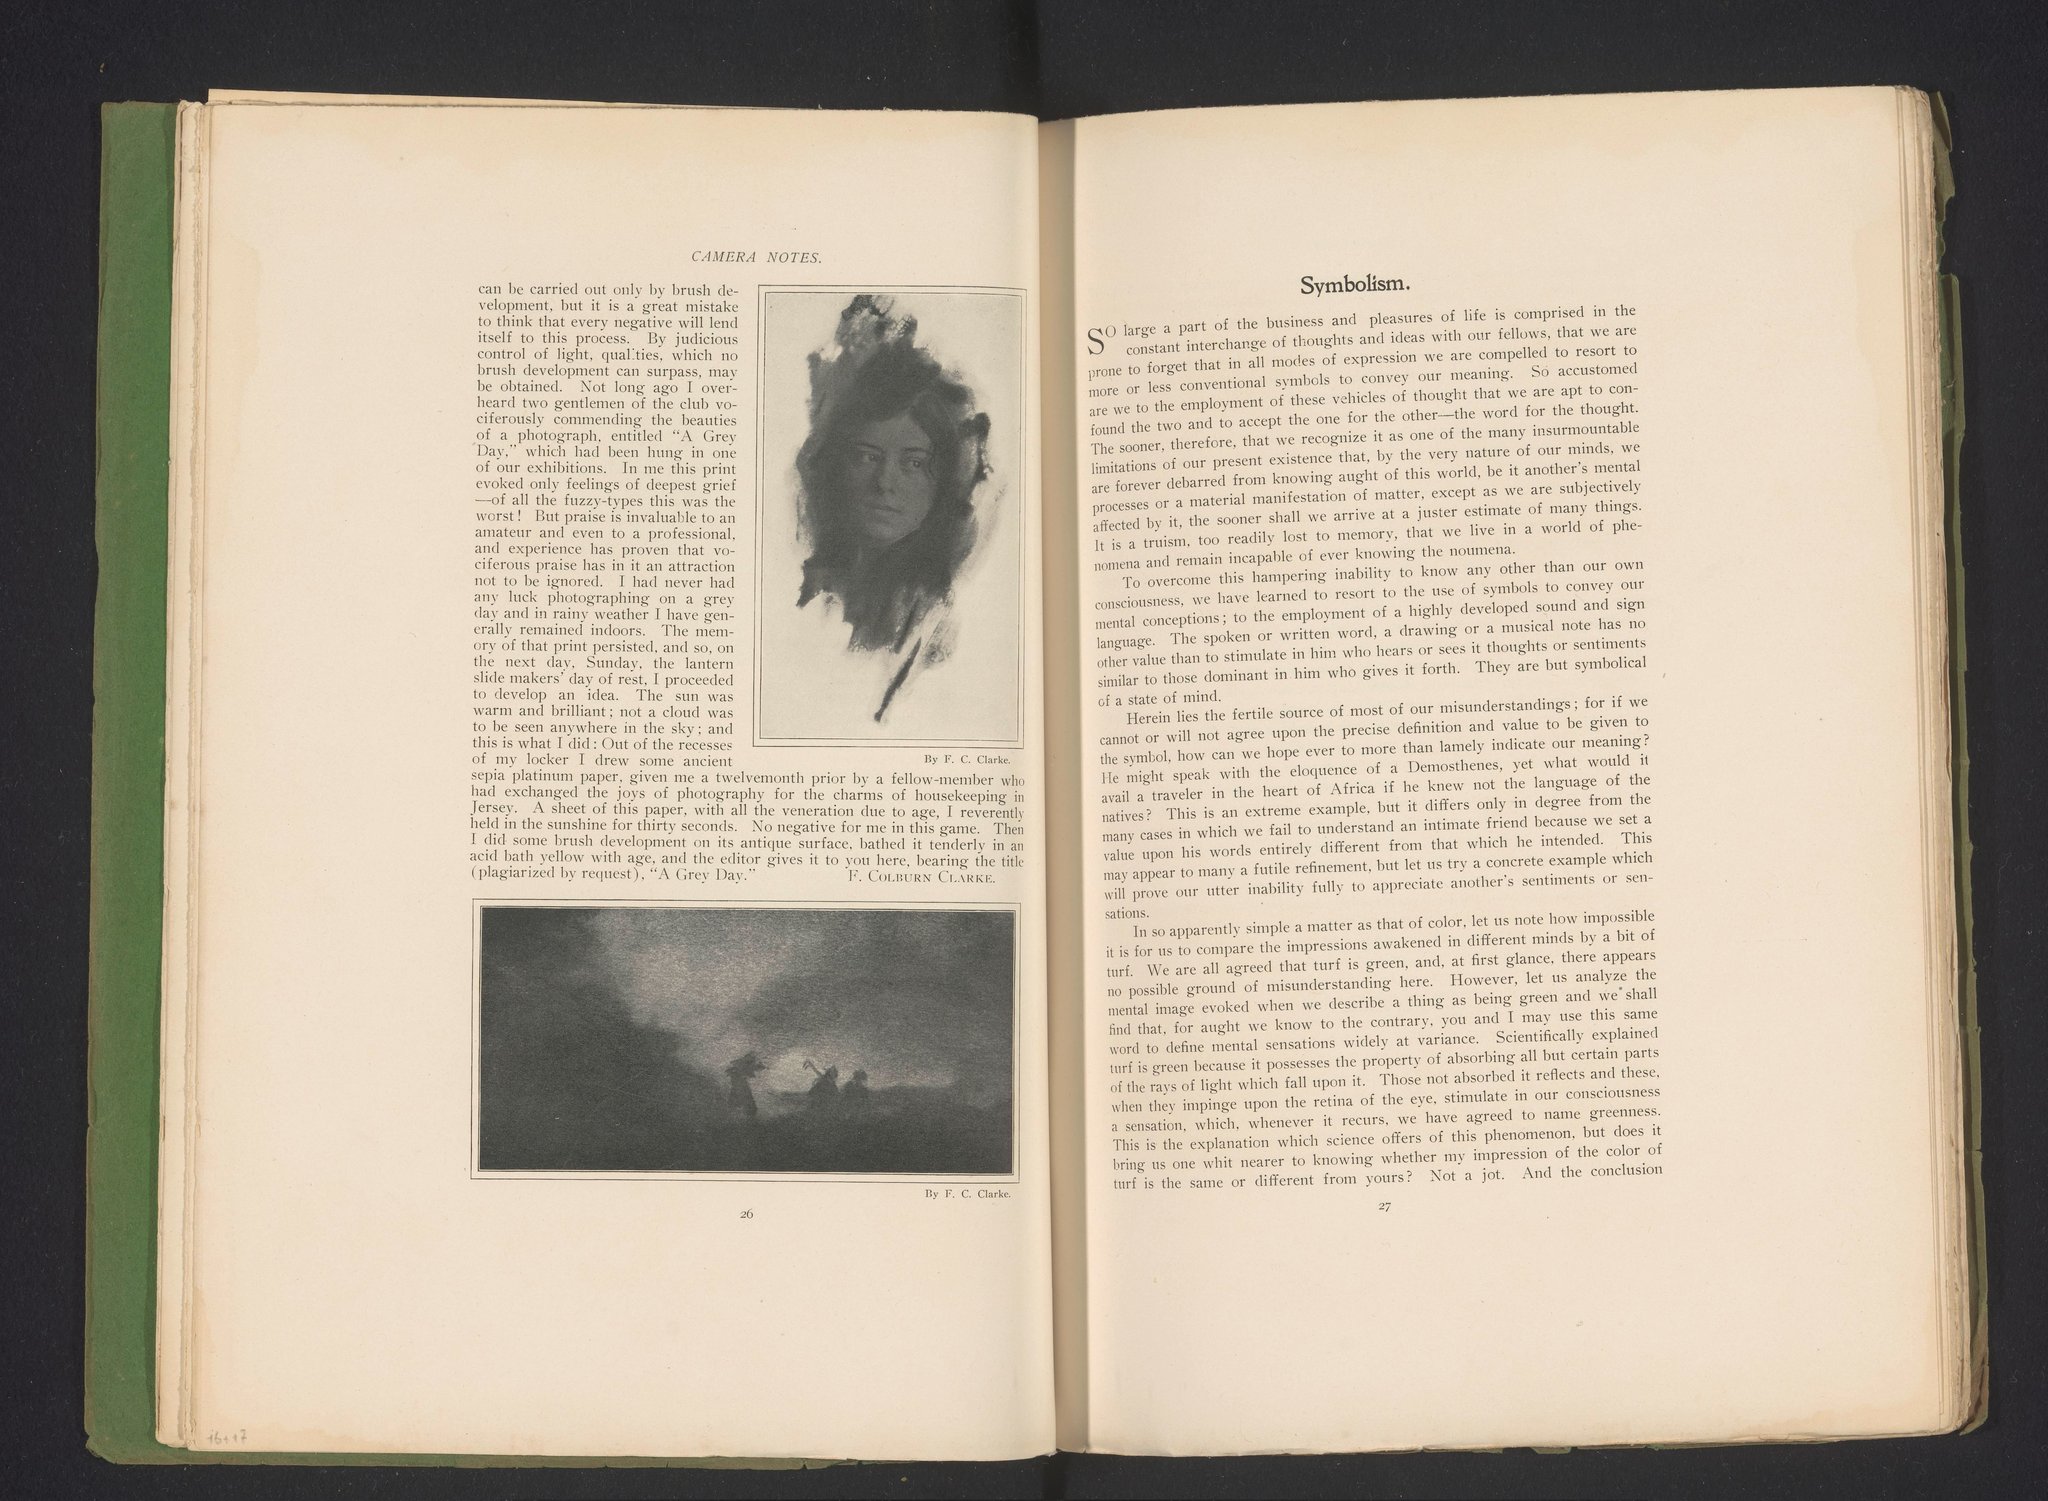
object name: page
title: Drie figuren in een nachtelijk landschap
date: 1896-1901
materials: paper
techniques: autotype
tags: huddled figure, night ~ landscape (sometimes titled 'nox')